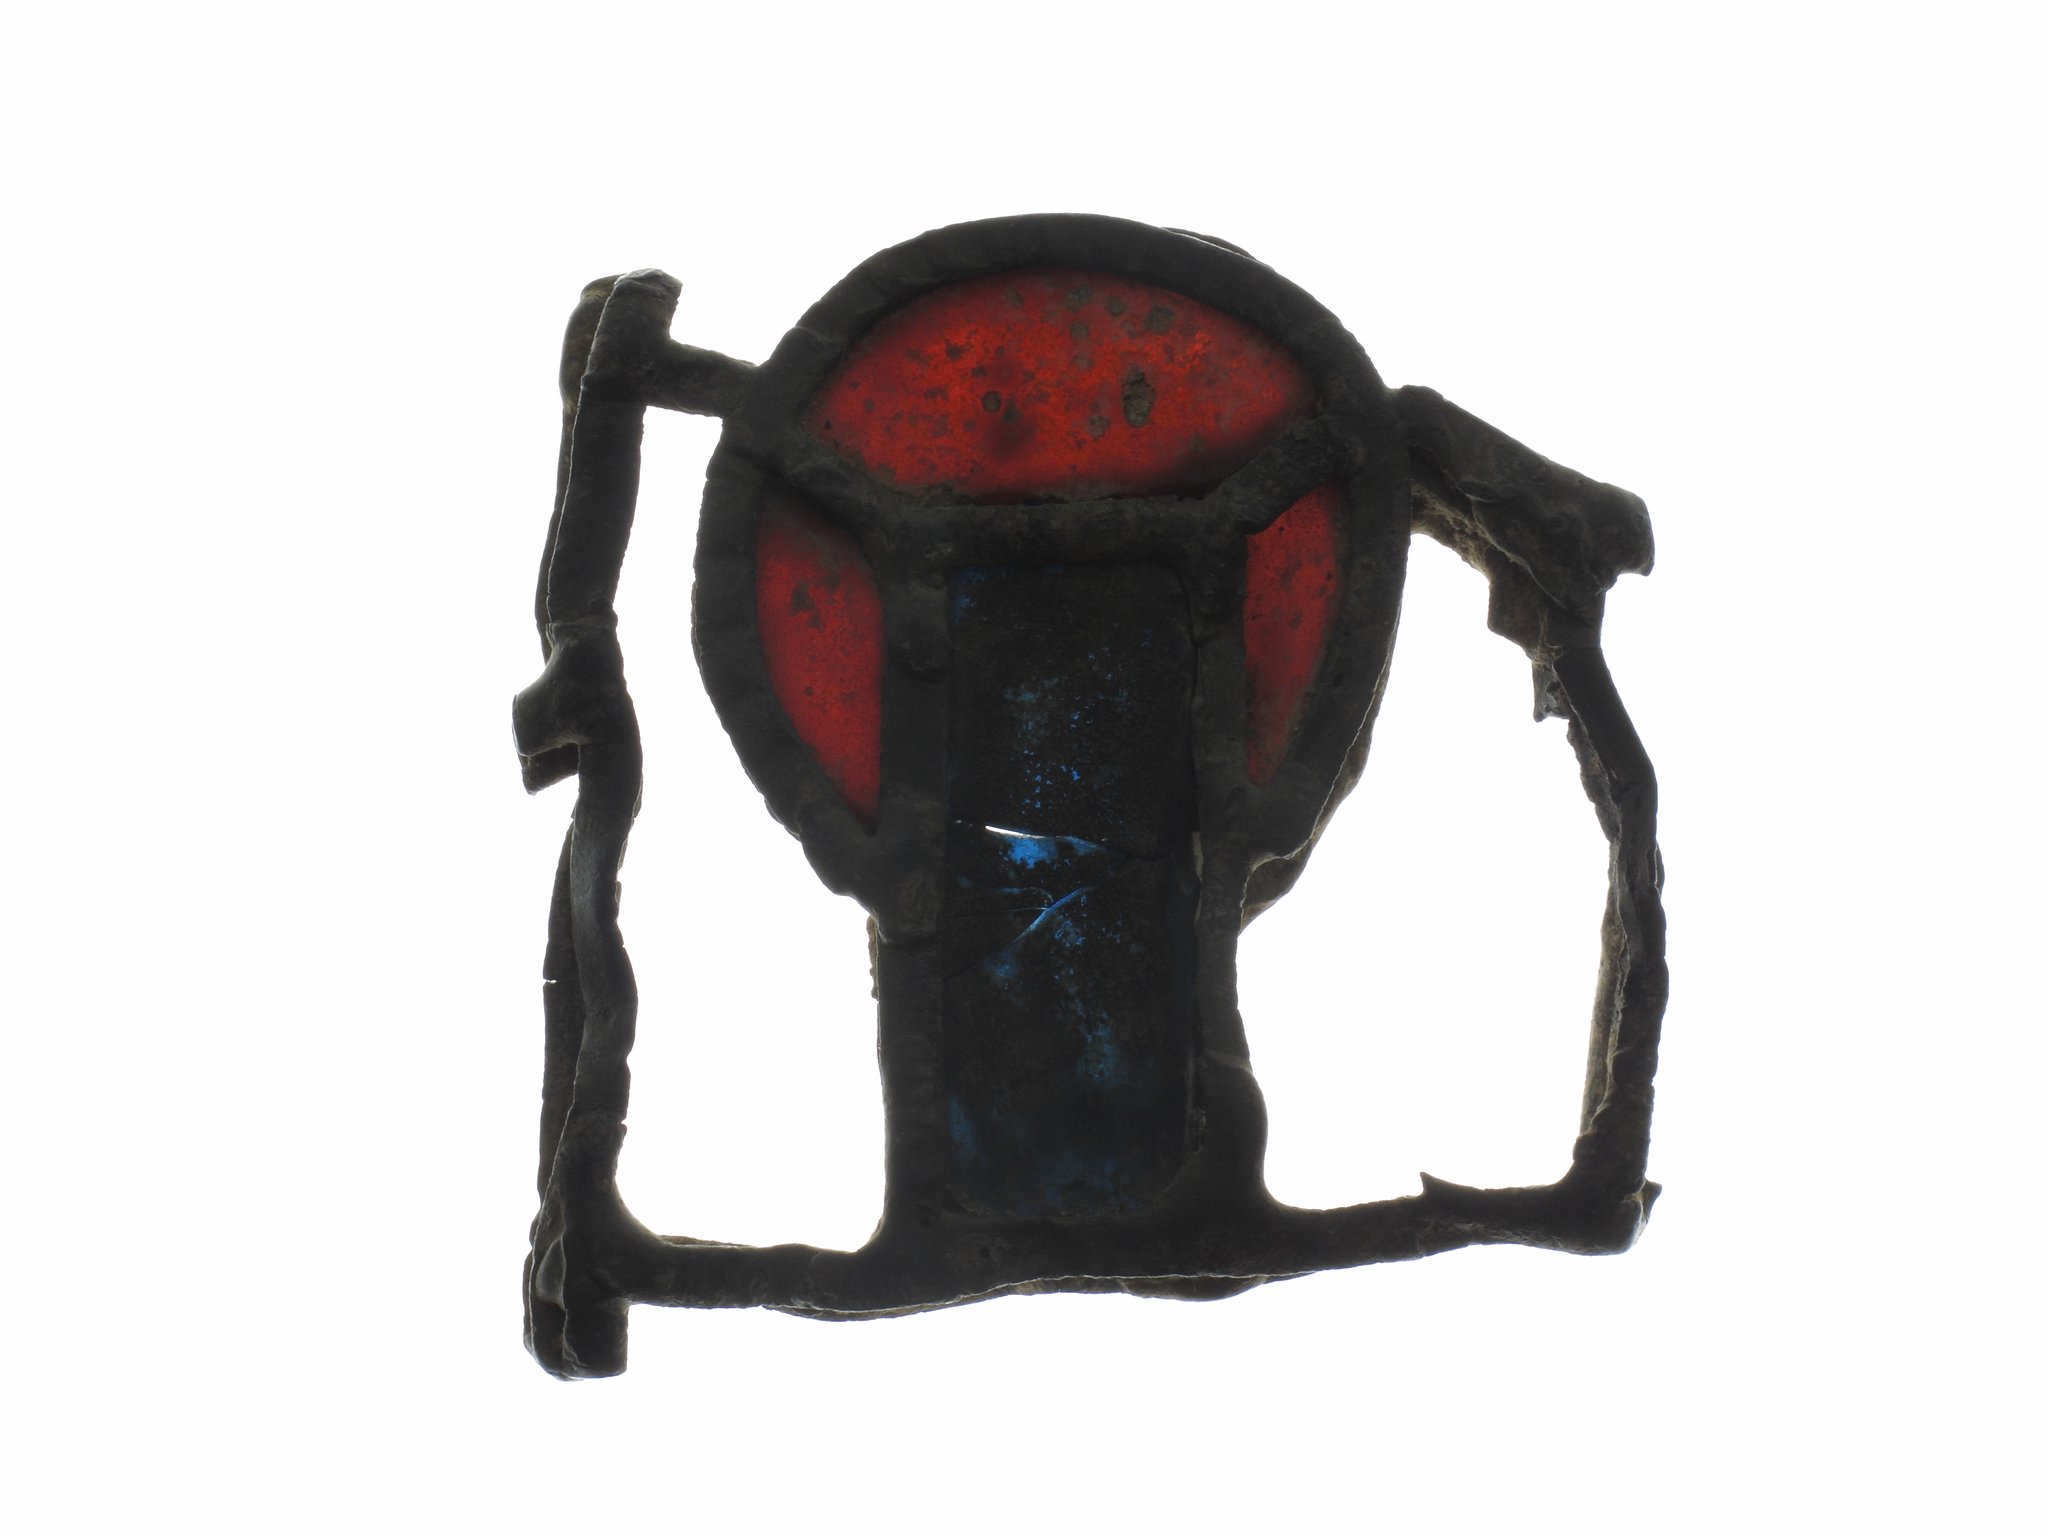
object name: fragment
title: Glass Fragment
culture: french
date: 1201-1300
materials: glass, lead